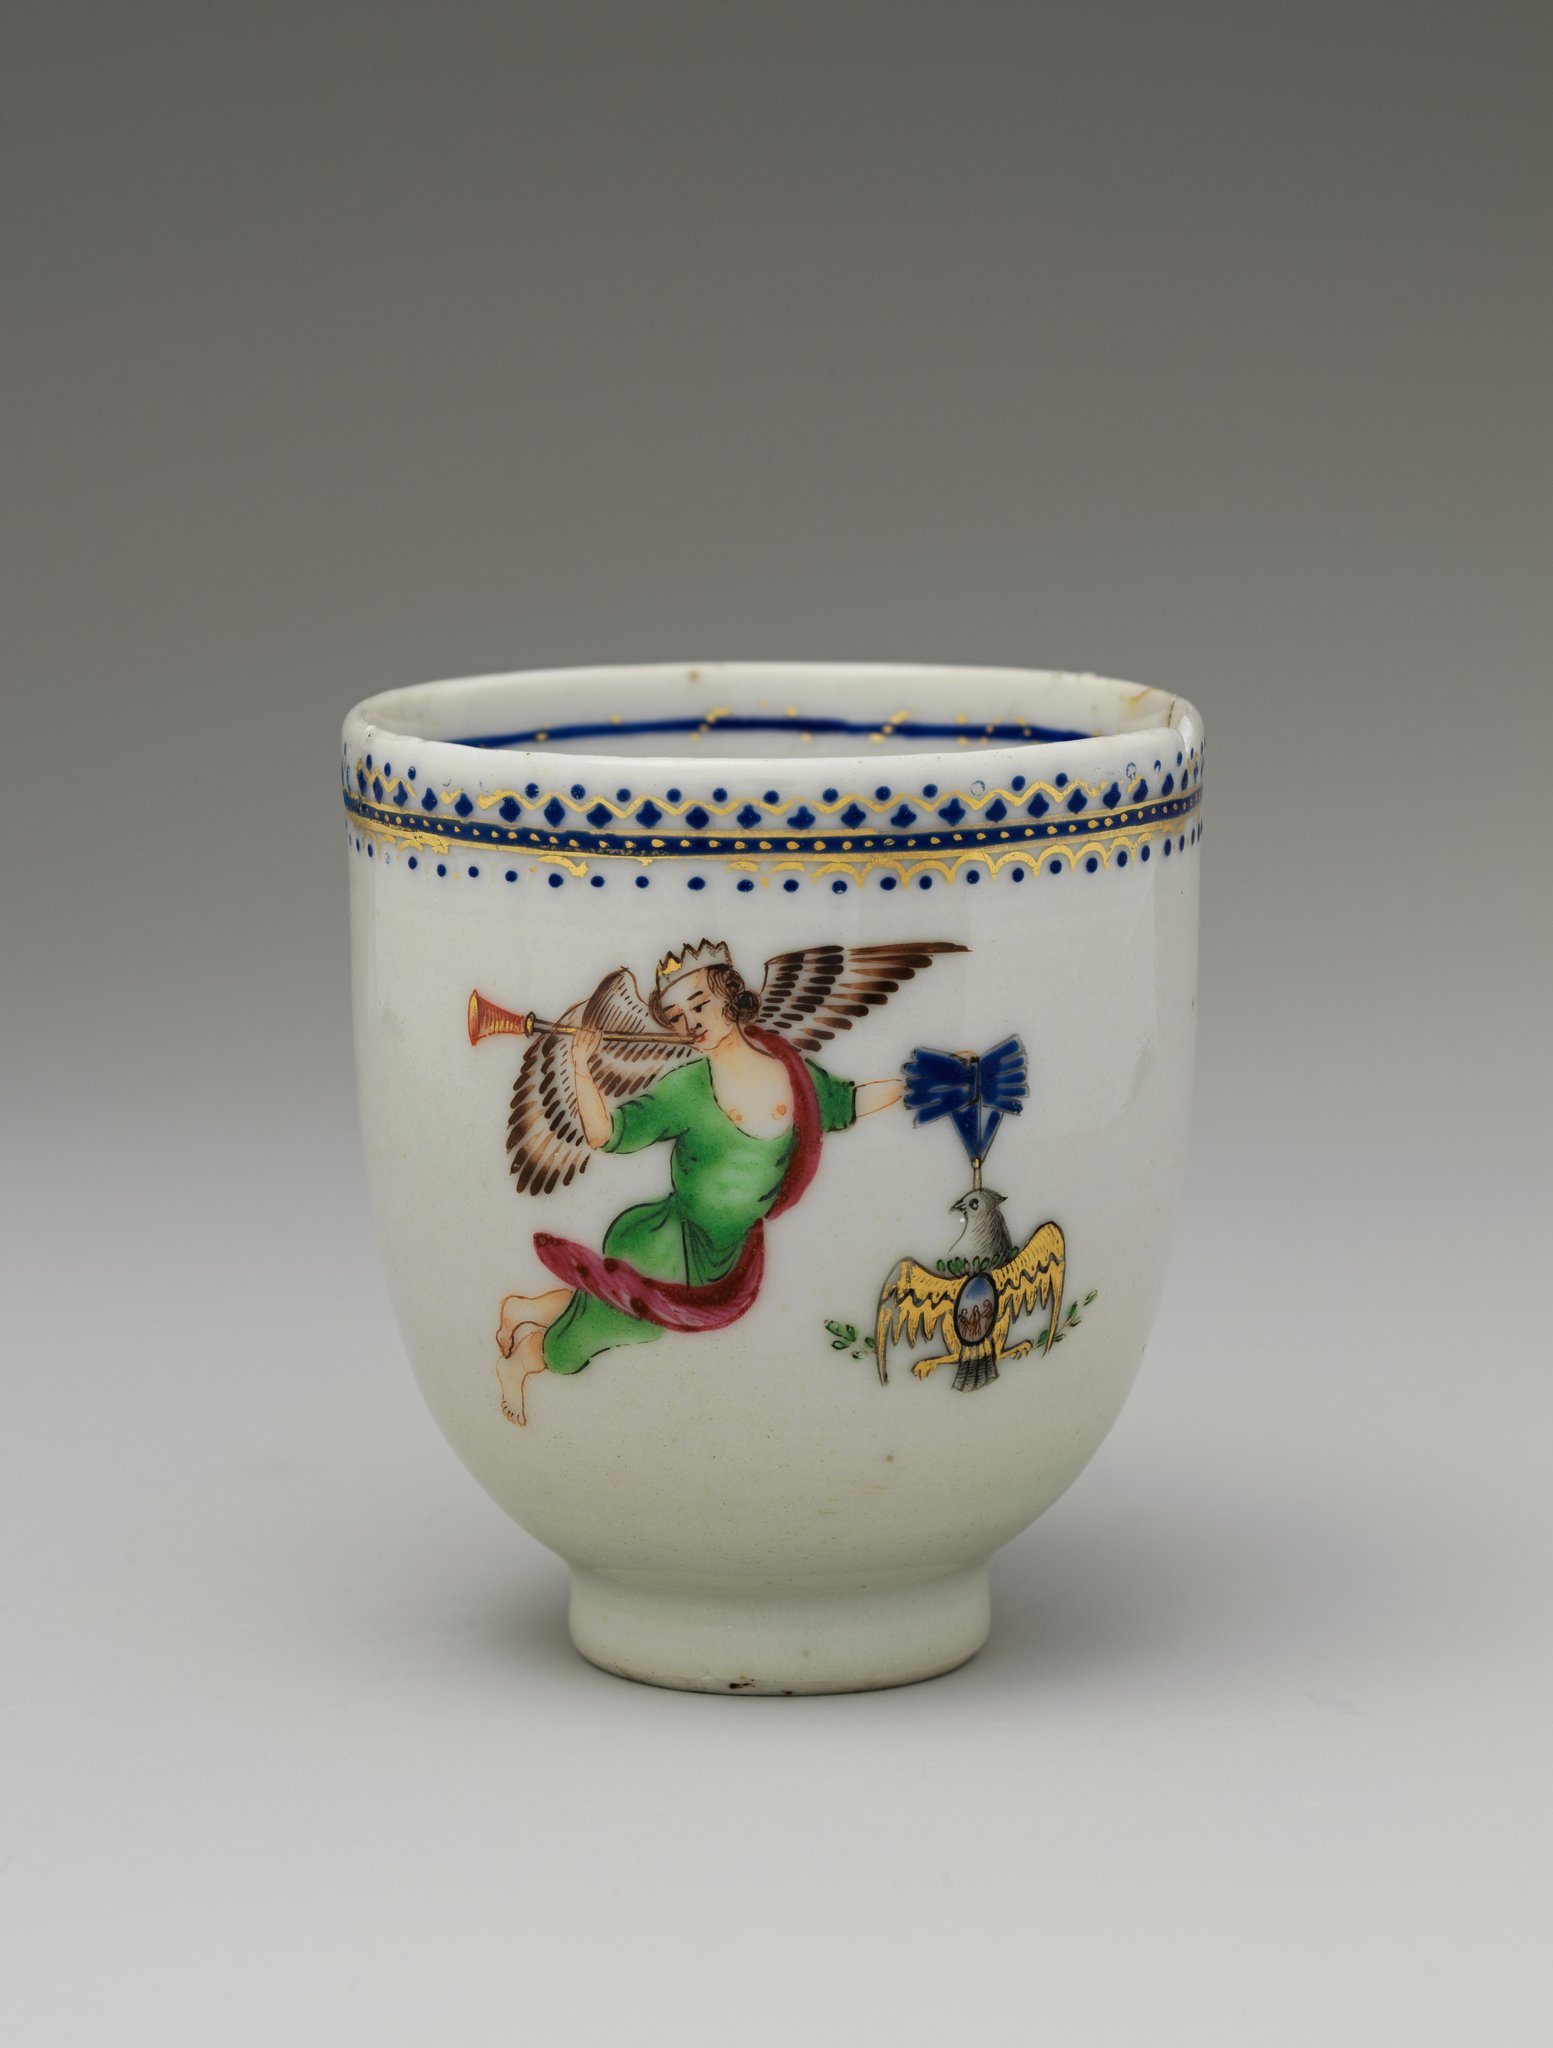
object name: coffee cup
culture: chinese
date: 1784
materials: porcelain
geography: china